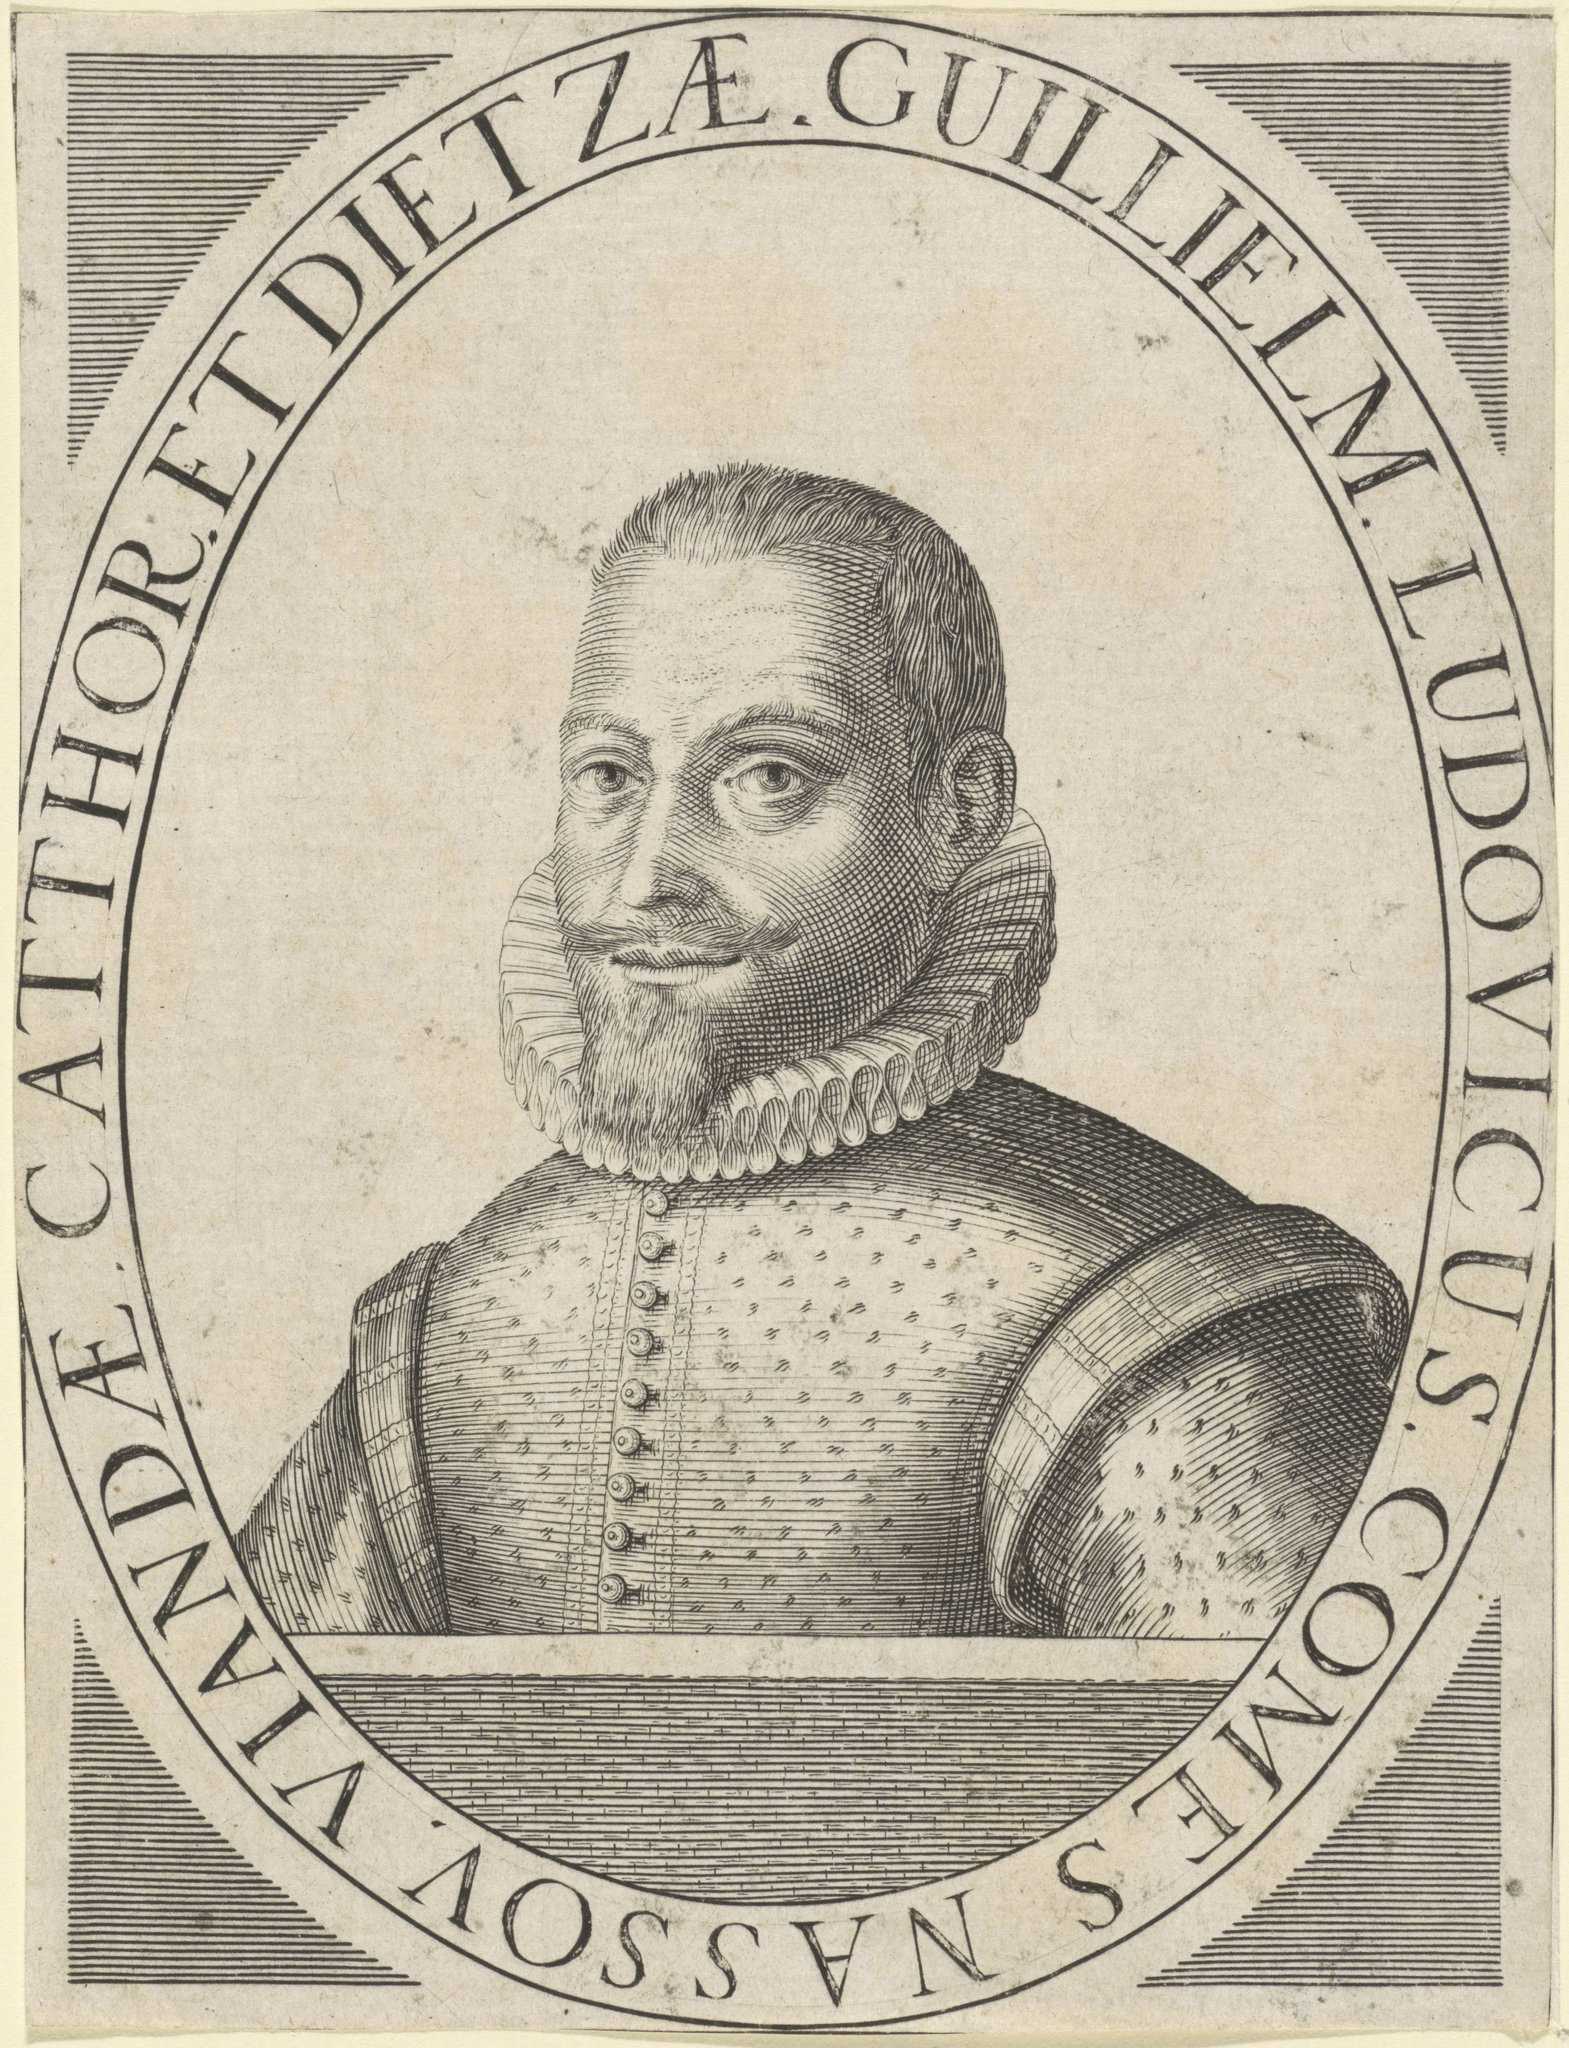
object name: print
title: Portret van Willem Lodewijk, graaf van Nassau-Dillenburg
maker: Anonymous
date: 1575-1649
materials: paper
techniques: engraving, etching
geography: low countries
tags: willem lodewijk graaf van nassau-dillenburg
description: De hier vermelde titel verwijst naar de hoogst verkregen titel van de geportretteerde, niet per se naar de titel die de geportretteerde op deze voorstelling draagt.